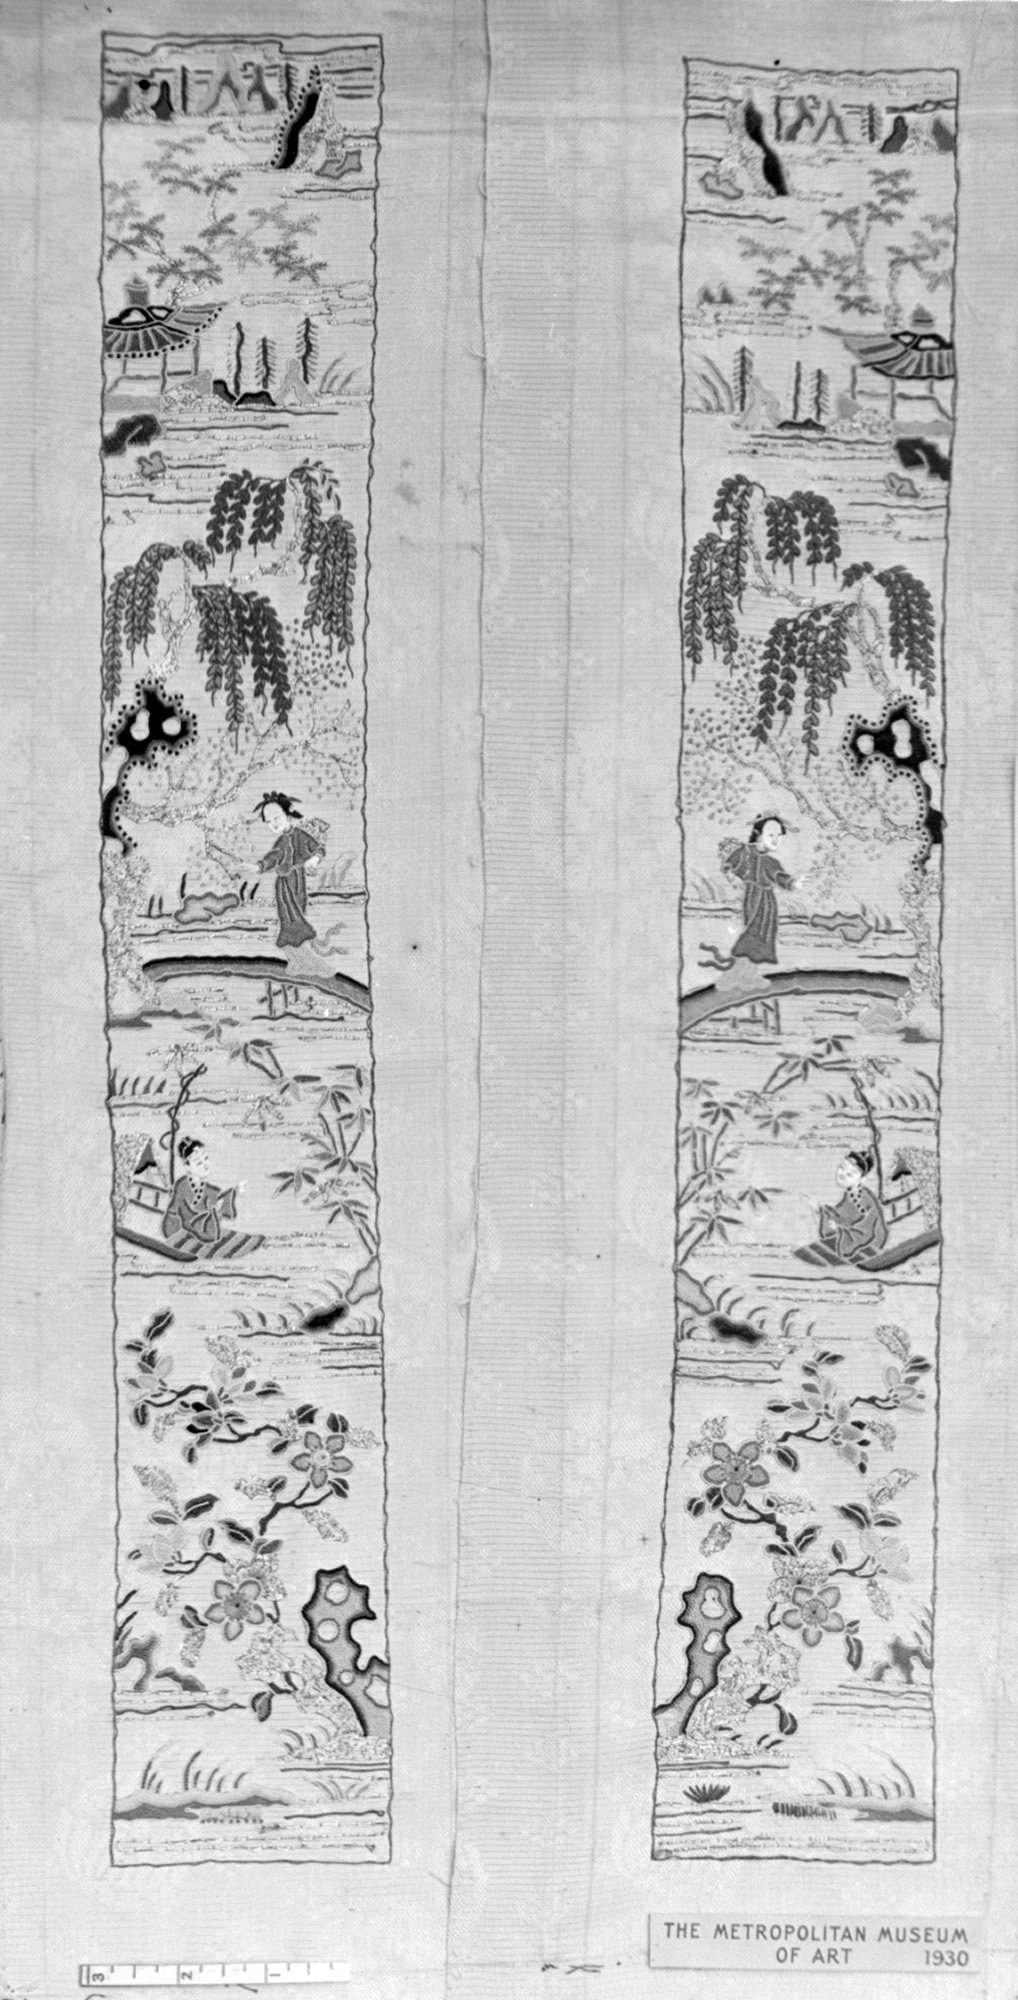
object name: sleeve band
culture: chinese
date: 1801-1900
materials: metal thread, silk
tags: human figures